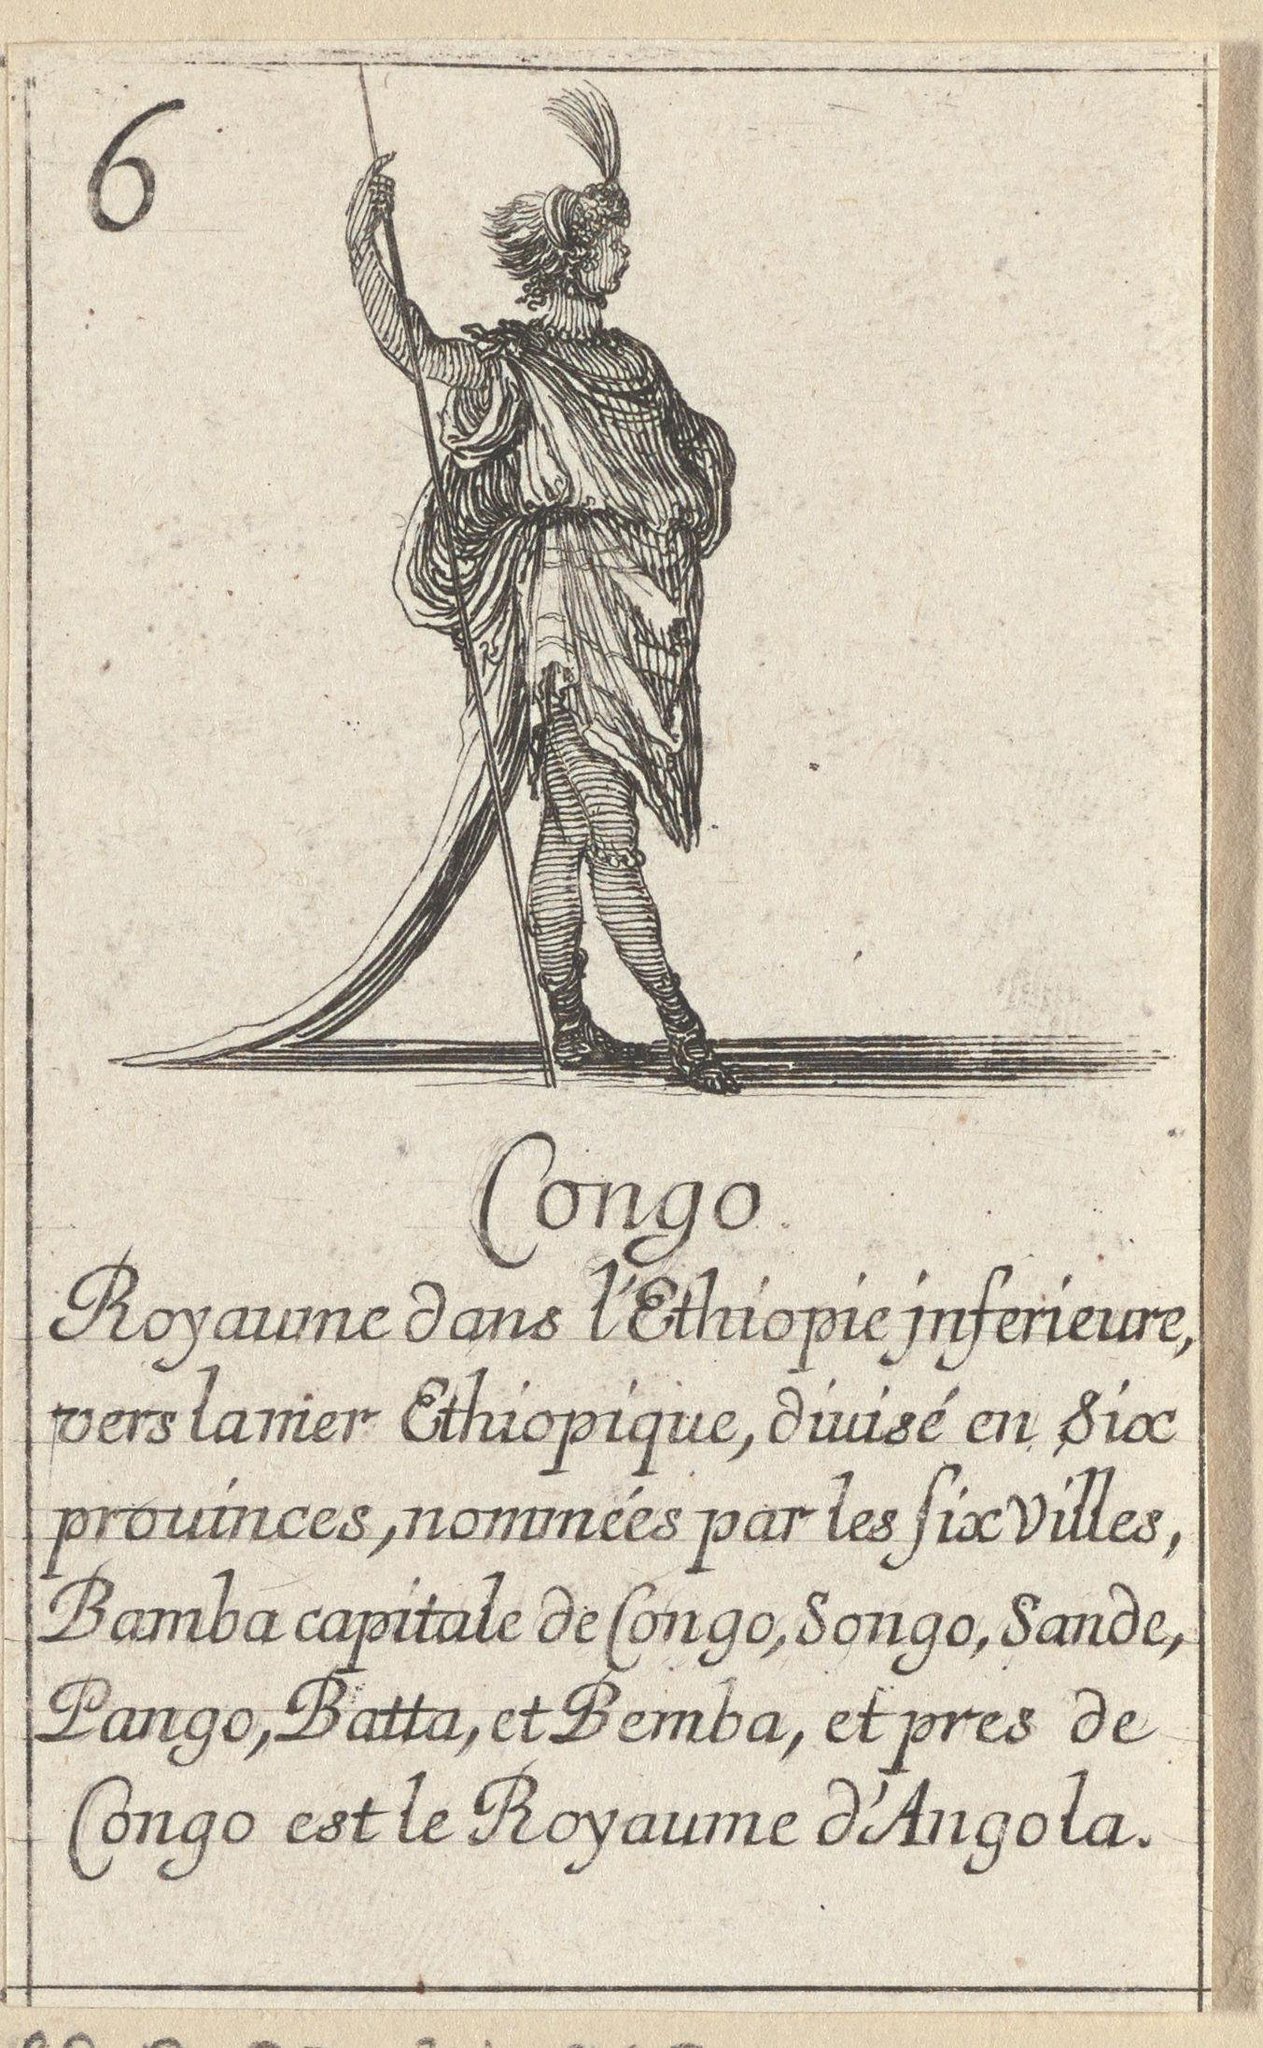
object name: print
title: Congo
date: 1620-1664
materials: paper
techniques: etching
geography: paris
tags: africans (+ costume)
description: Deze prent maakt deel uit van een kaartspel met 52 kaarten met voorstellingen van vrouwen uit landen over de hele wereld. De serie is uitgedacht door Jean Desmarests de Saint-Sorlin in opdracht van Kardinaal Mazarin. Het kaartspel werd gemaakt voor de jonge Lodewijk XIV, samen met het Jeu des Fables, Jeu des Reynes Renommées en Jeu des Rois de France.